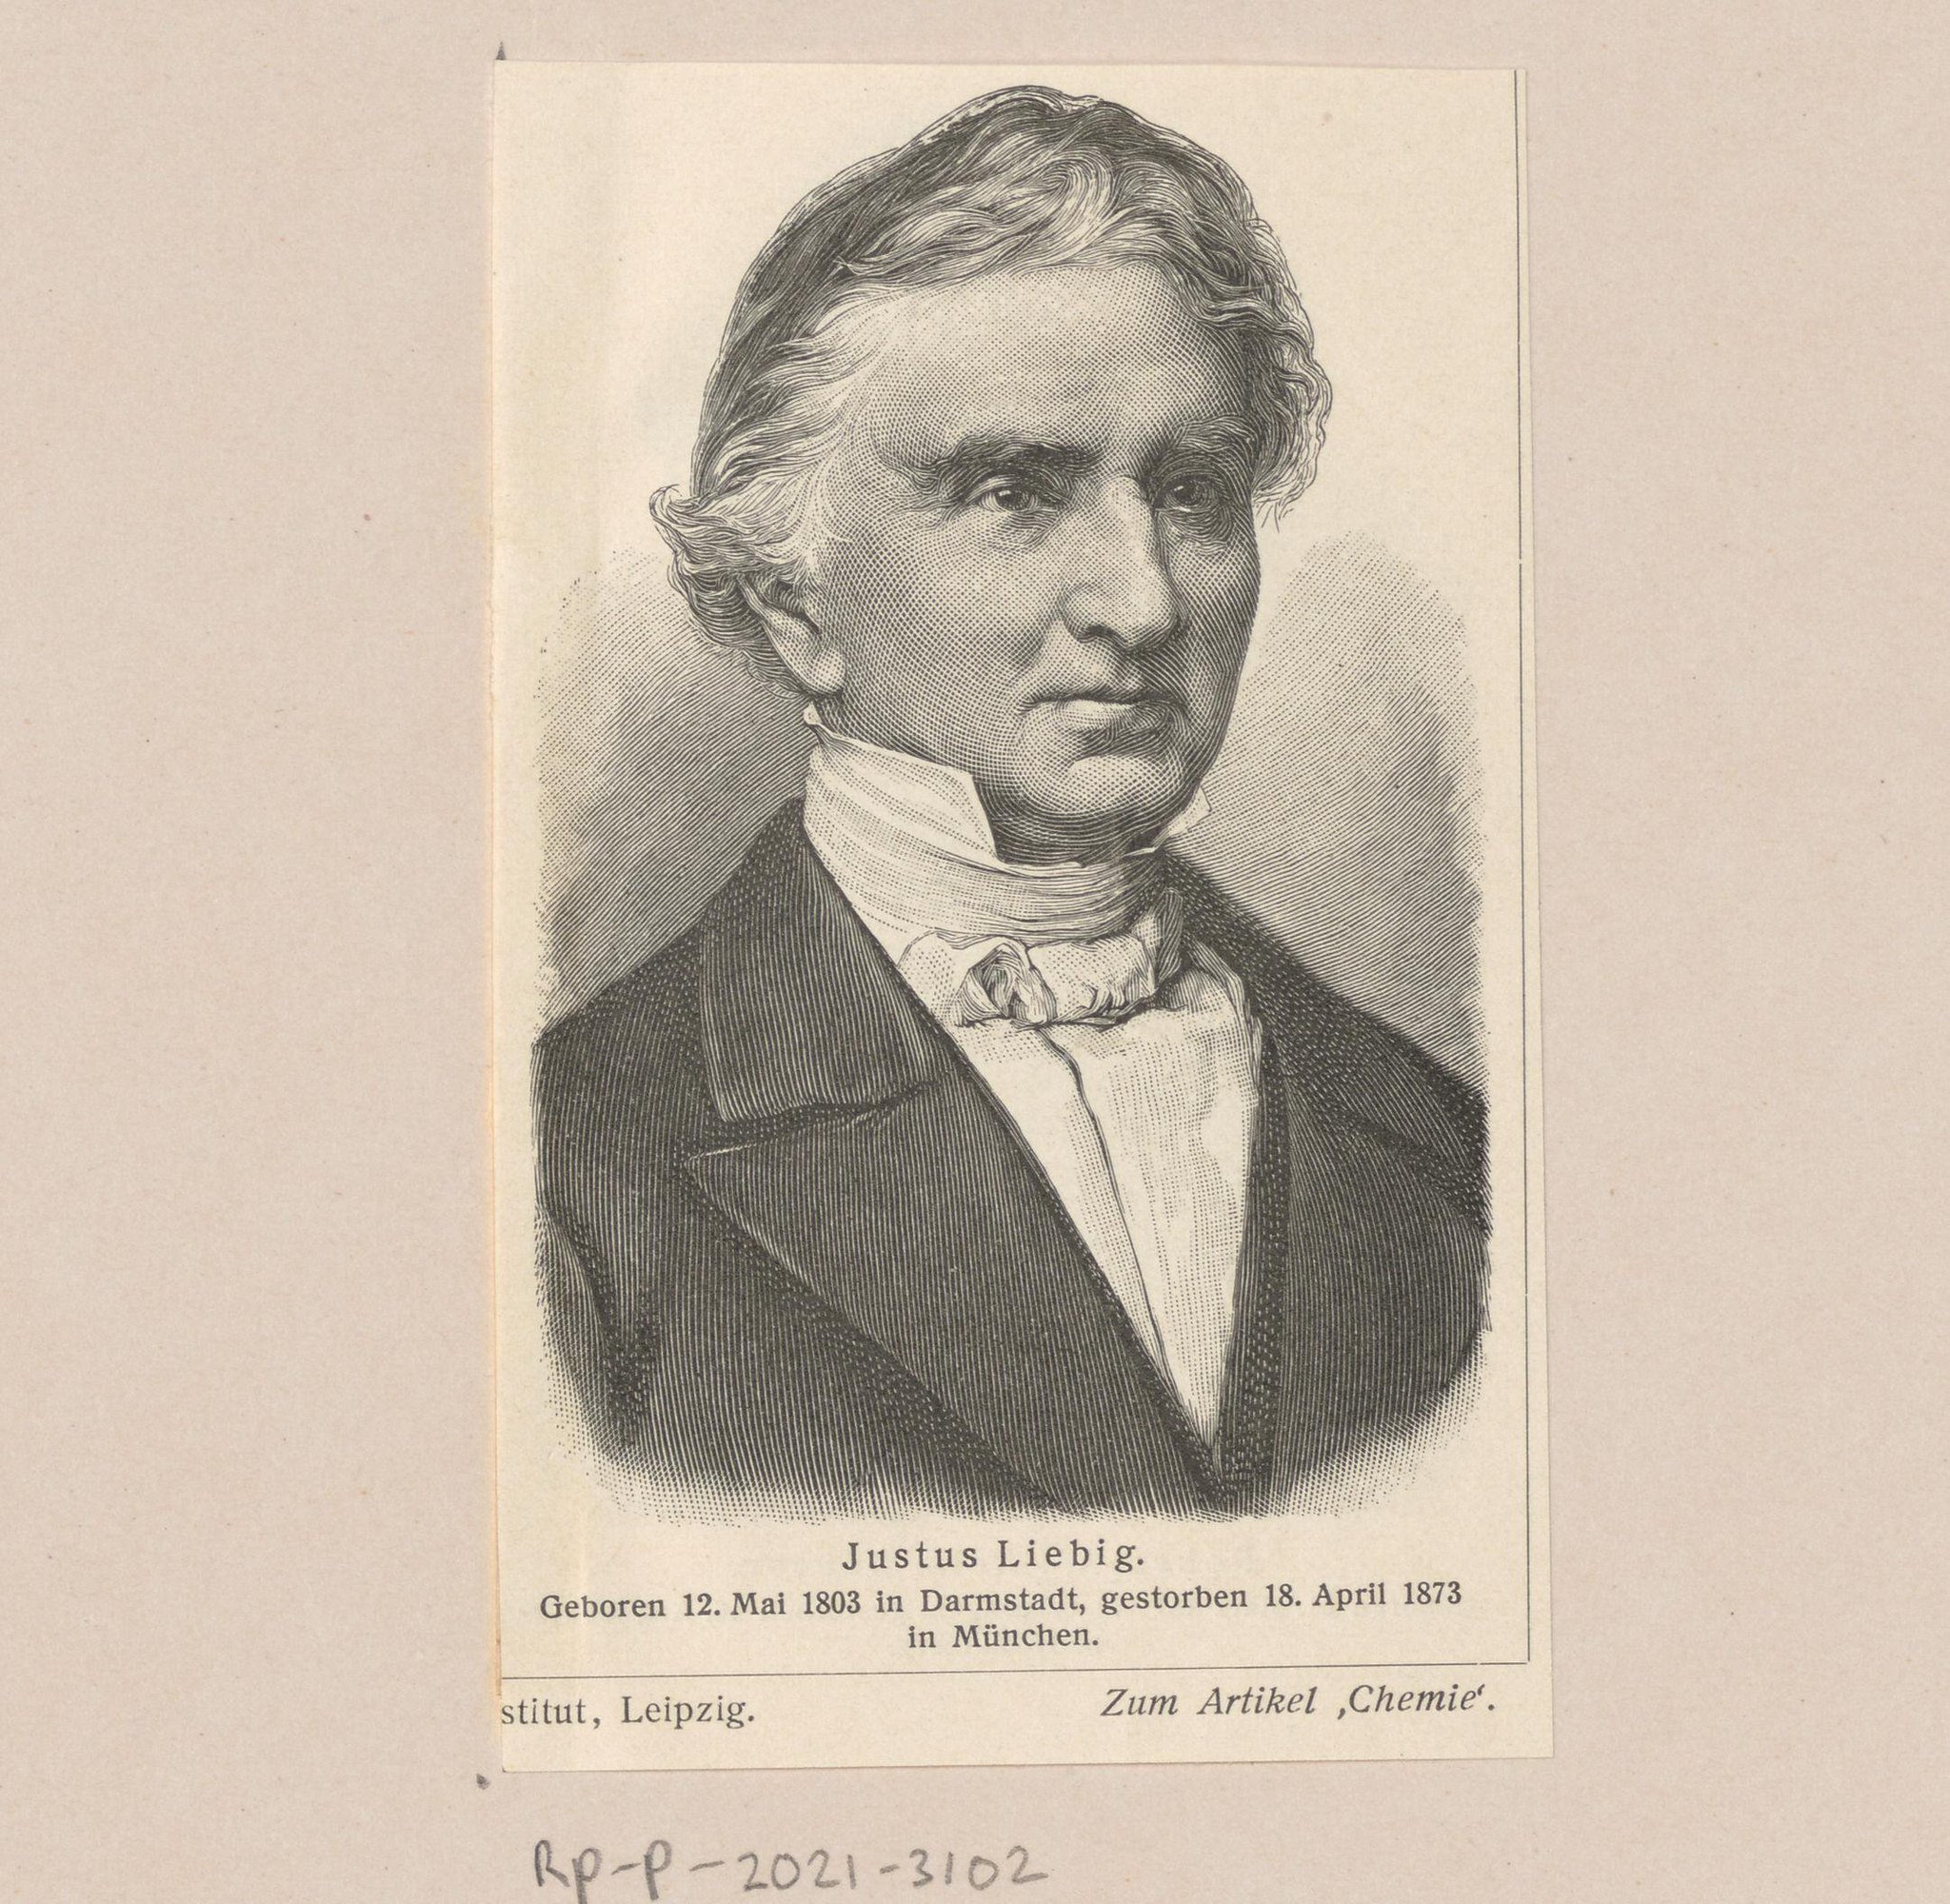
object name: print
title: Portret van Justus von Liebig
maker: Anonymous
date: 1873-1920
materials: paper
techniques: letterpress printing, engraving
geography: germany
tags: chemistry (+ portrait of scholar, scientist), historical persons